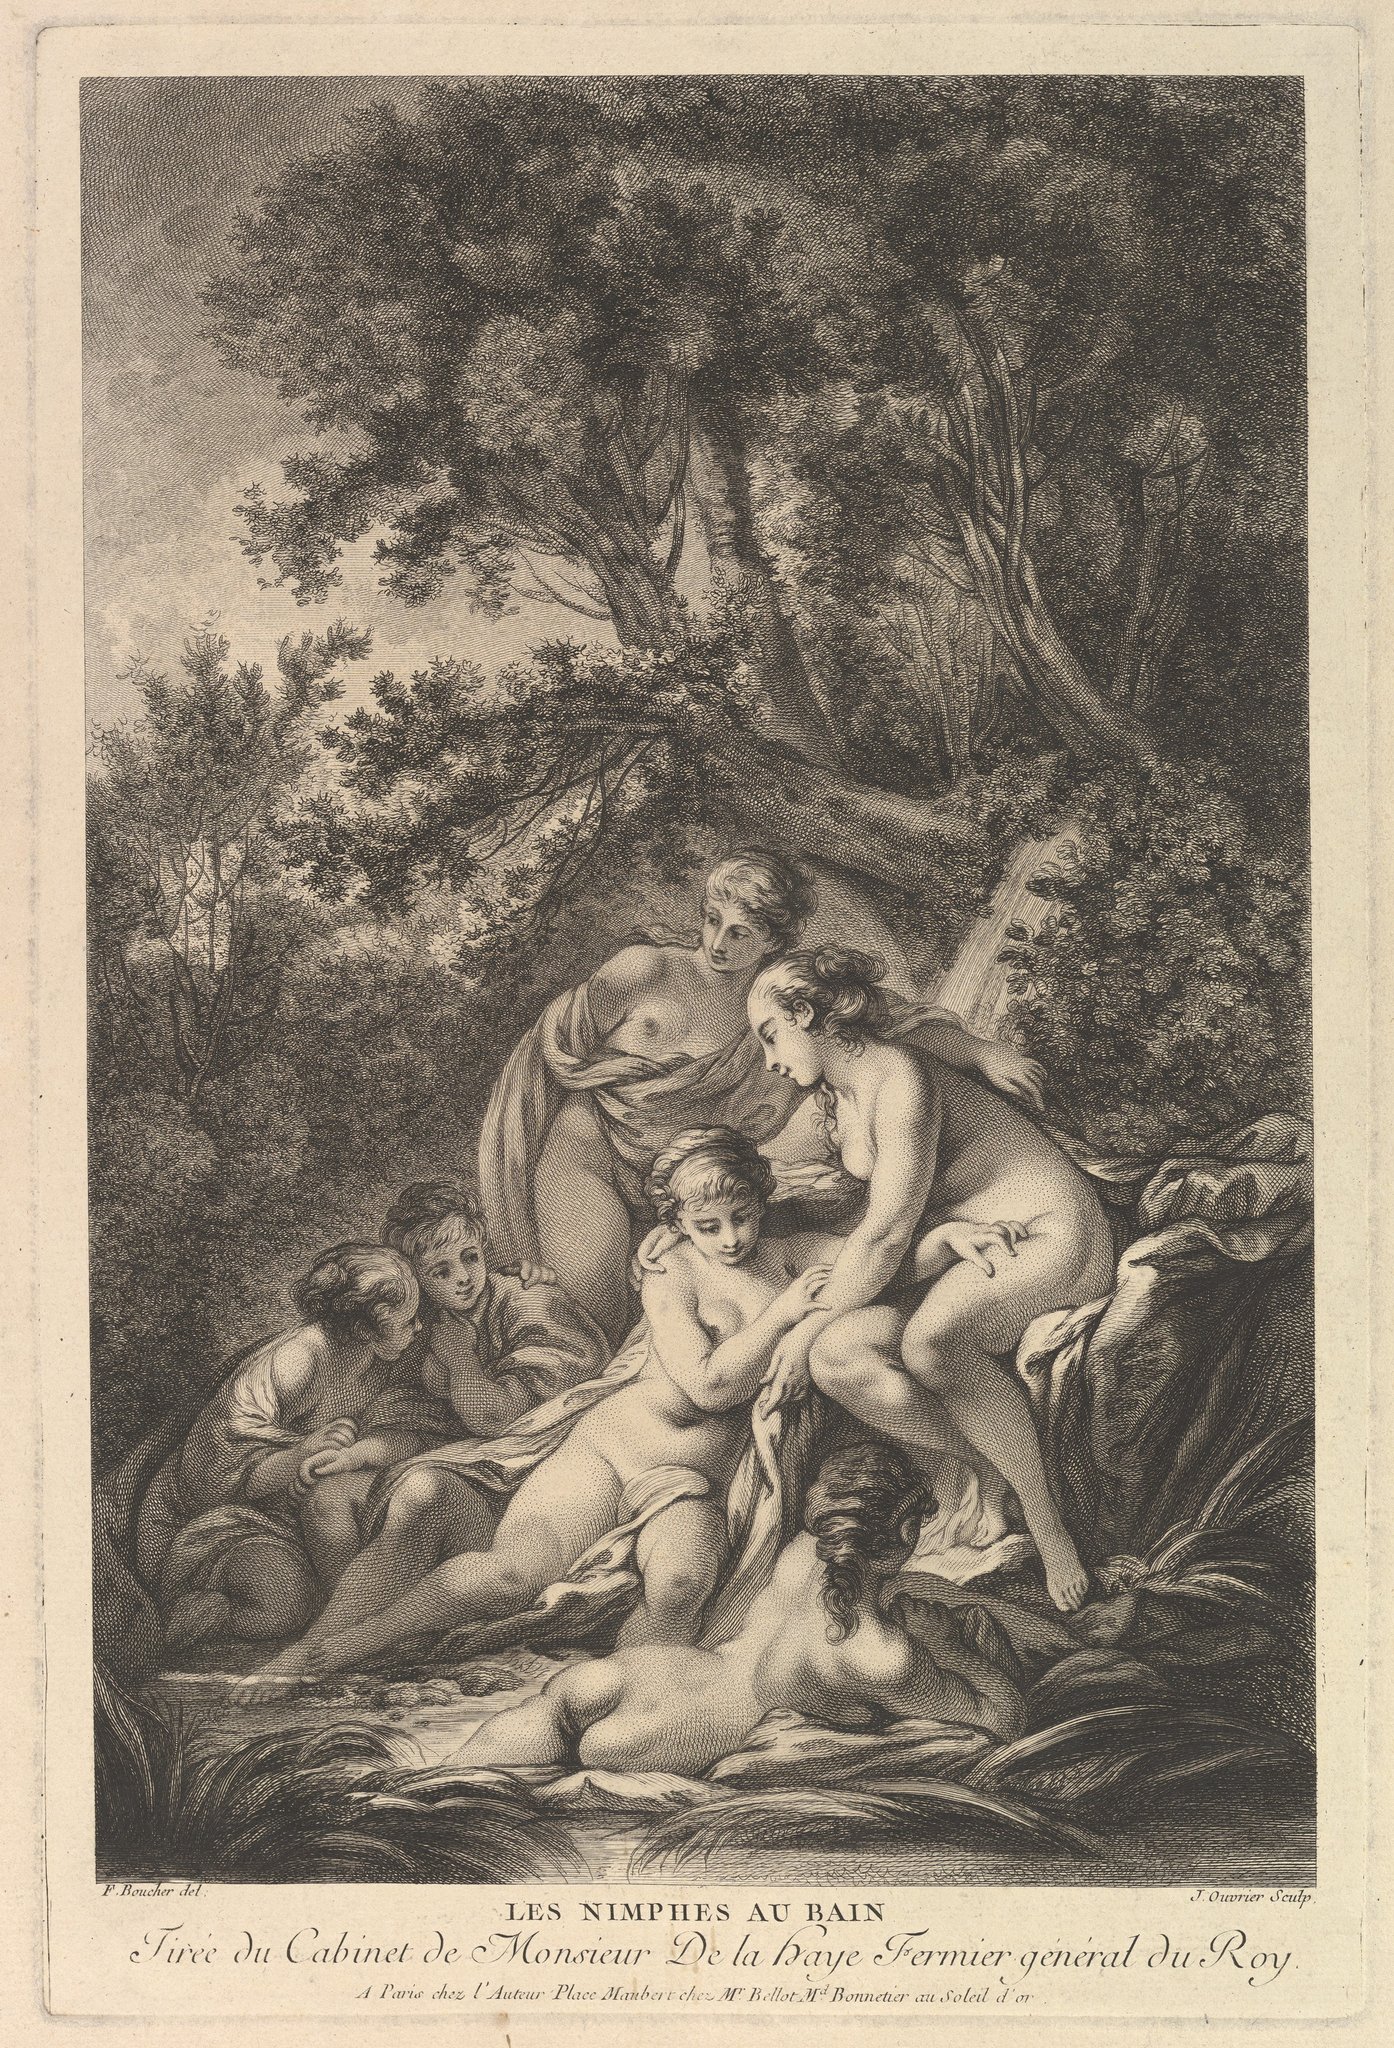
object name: print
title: Les Nimphes au Bain (The Nymphs at the Bath)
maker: jean ouvrier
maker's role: artist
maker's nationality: french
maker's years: 1725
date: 1701-1800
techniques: engraving, etching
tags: female nudes,nymphs,bathing